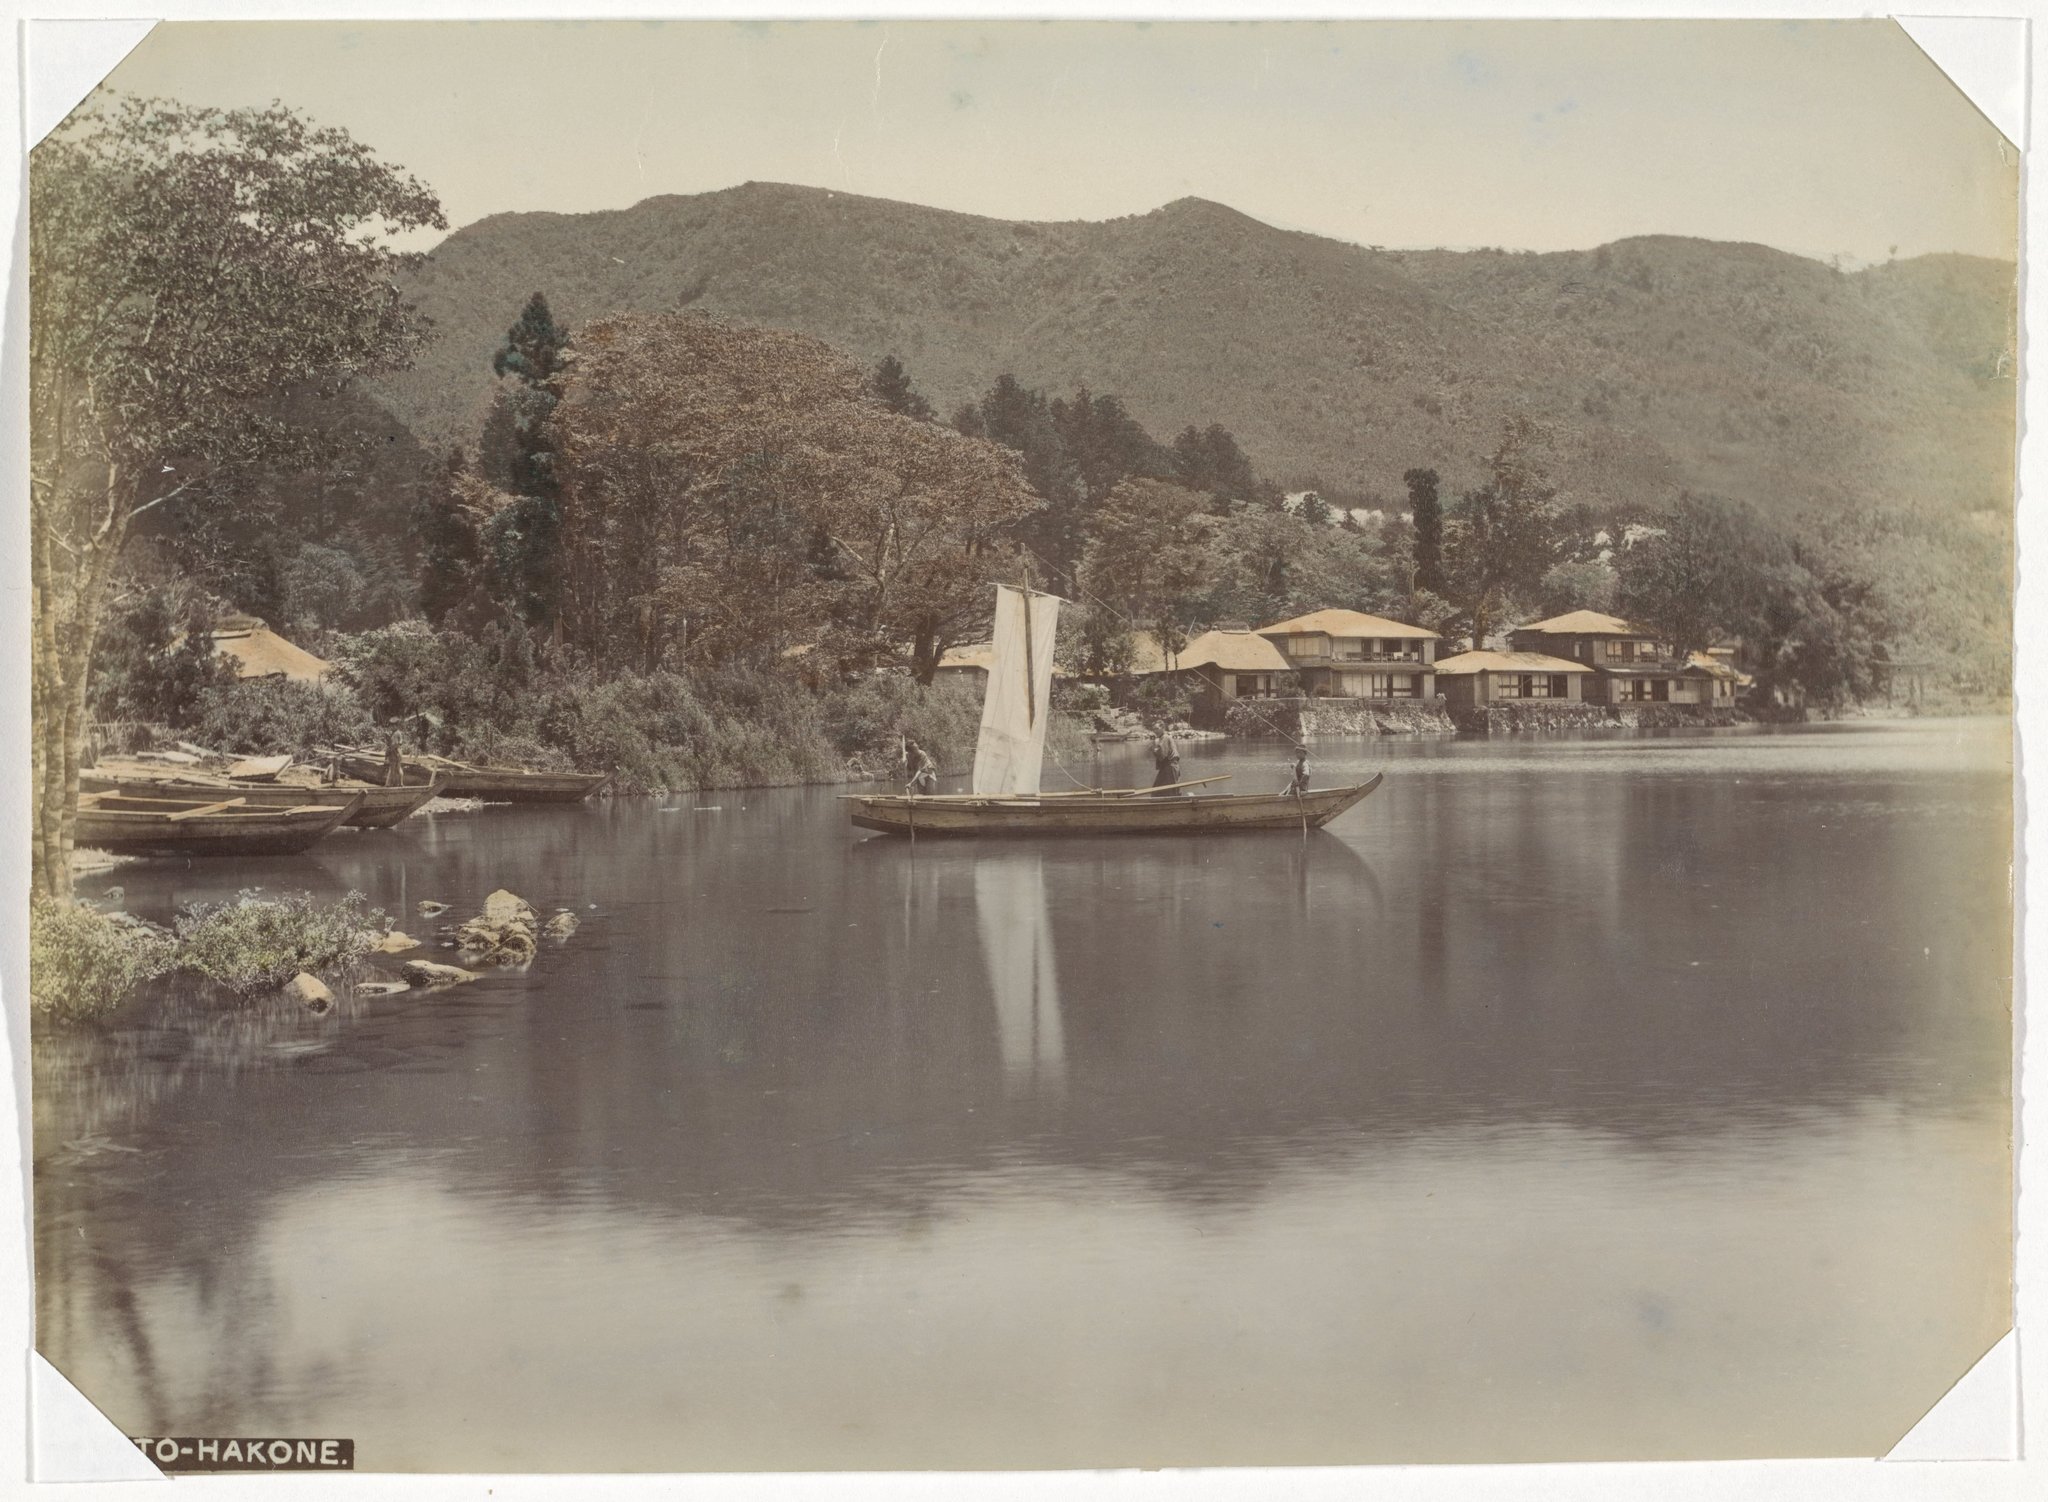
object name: photograph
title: Moto Hakone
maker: Anonymous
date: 1890-1894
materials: cardboard, paper, photographic support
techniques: albumen print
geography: hakone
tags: lake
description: Onderdeel van Album met 69 foto's van een reis door Japan.